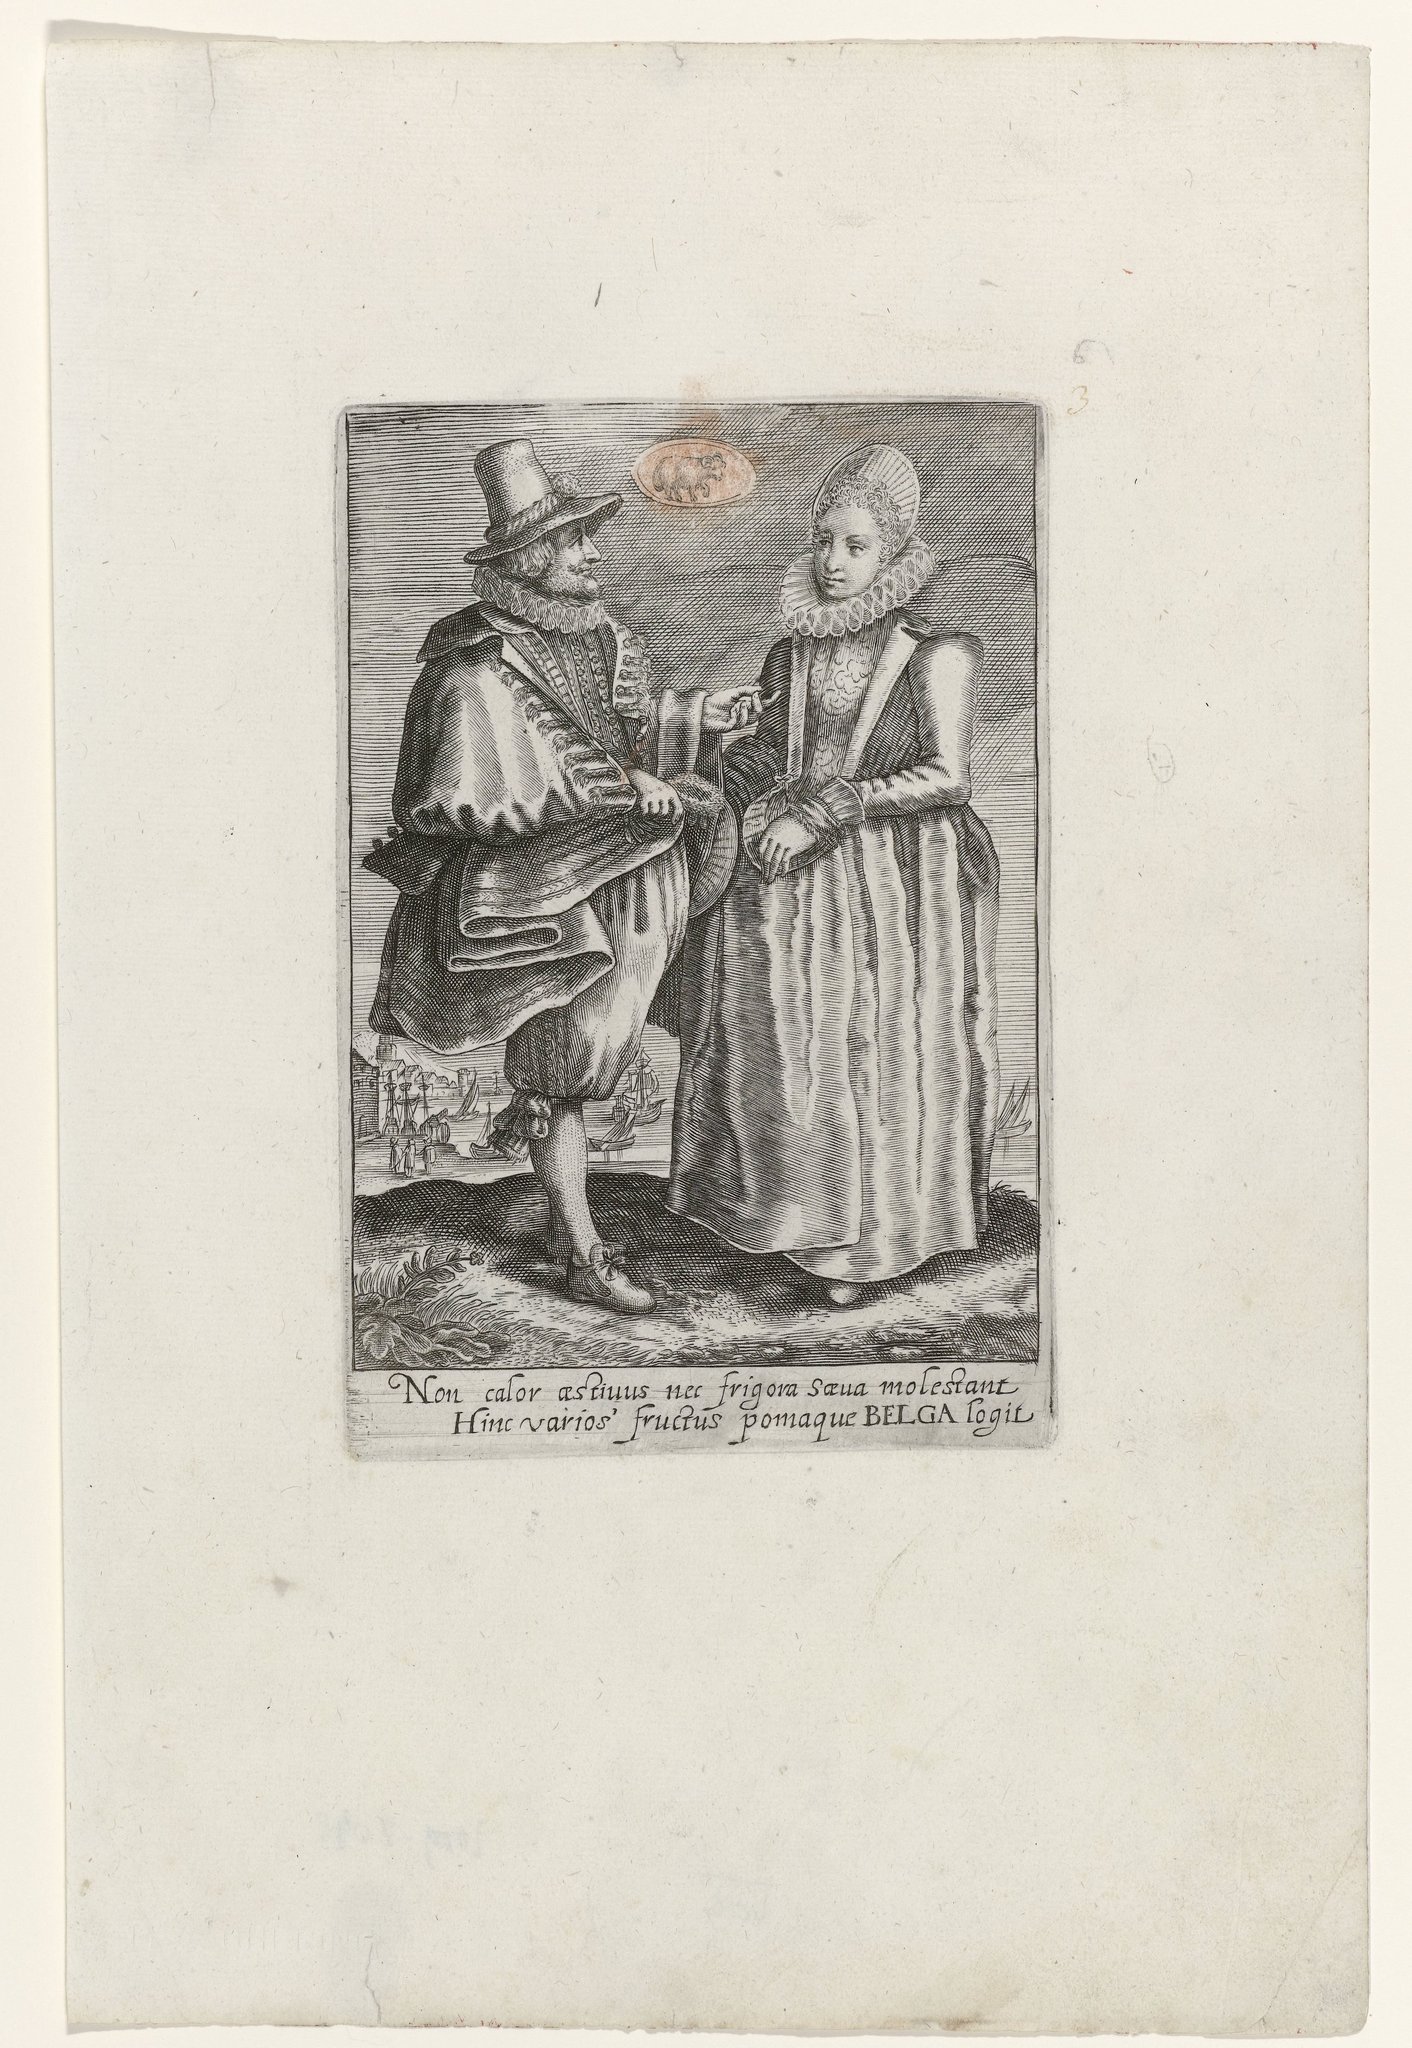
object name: costume print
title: Maart: een paar uit de Nederlanden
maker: crispijn van de passe (ii)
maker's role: draughtsman, print maker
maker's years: 1594-1670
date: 1615-1620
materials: paper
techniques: engraving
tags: cape (+ men's clothes), head-gear (boogmuts) (+ women's clothes), head-gear: hat (+ men's clothes), head-gear: cap (+ women's clothes), clothes, costume (+ women's clothes), neck-gear ~ clothing (with name) (+ women's clothes), skirt (+ women's clothes), sleeves: cuffs (+ women's clothes), shoes, sandals (+ men's clothes), clothes, costume (+ men's clothes), aries (zodical sign of march), trousers, breeches, etc. (breeches) (+ men's clothes), apron (+ women's clothes), clothing for the upper part of the body (doublet) (+ men's clothes), sleeves (+ women's clothes), clothing for the upper part of the body (with name) (+ women's clothes), march ~ other concepts, europeans (with name) (+ costume), low countries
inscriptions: caption (possibly false): ‘Non calor aestiuus nec frigora saeua molestant / Hinc varios fructus pomaque BELGA logit. [legit]’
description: Man en vrouw uit de Nederlanden, gekleed volgens de mode van ca. 1625. Boven hen het teken van de Ram. Op de achtergrond gezicht op een haven. In de marge een tweeregelig onderschrift in het Latijn waaruit blijkt dat het klimaat voor de Nederlander geen storende factor is. Prent uit een serie met de twaalf maanden weergegeven door tekens van de dierenriem en paren die kleding uit verschillende landen dragen.